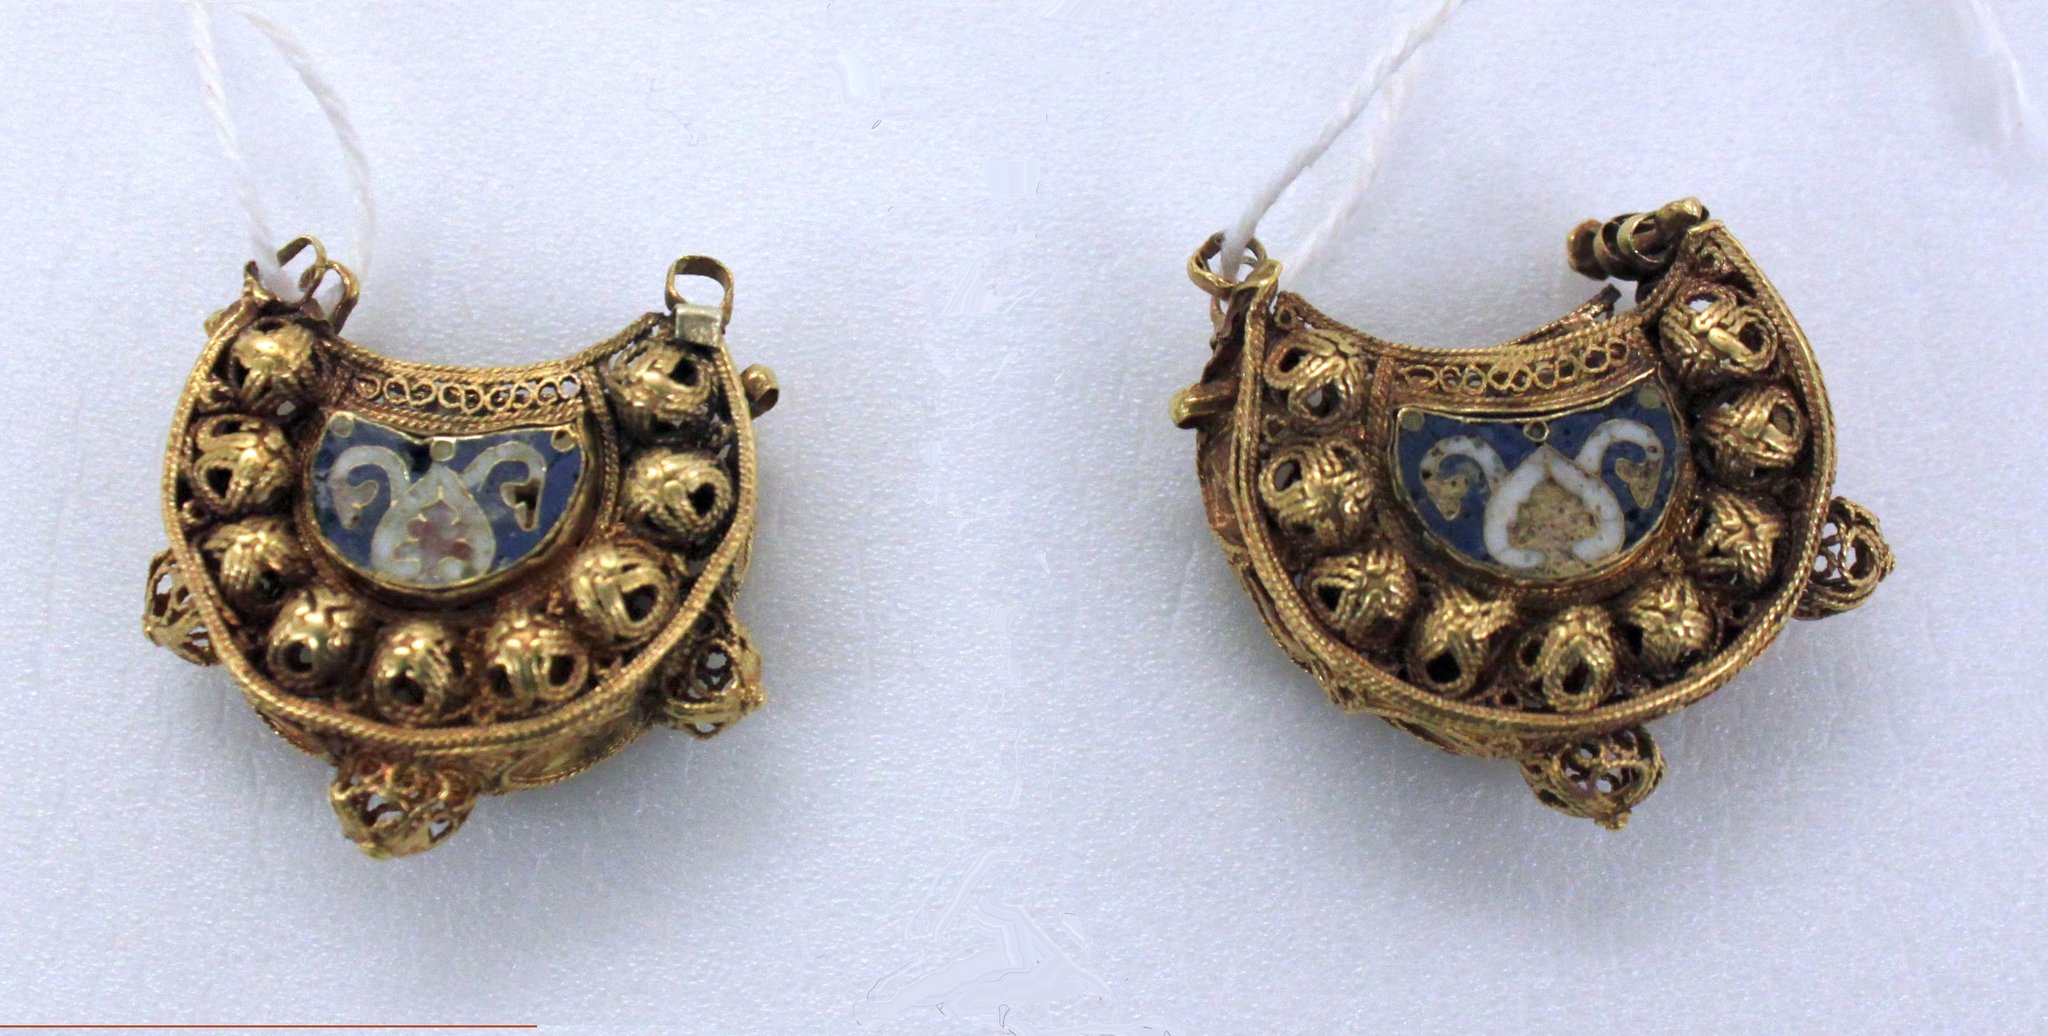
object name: earring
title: Earrings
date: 1001-1200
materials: enamel, gold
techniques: enamel, filigree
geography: syria